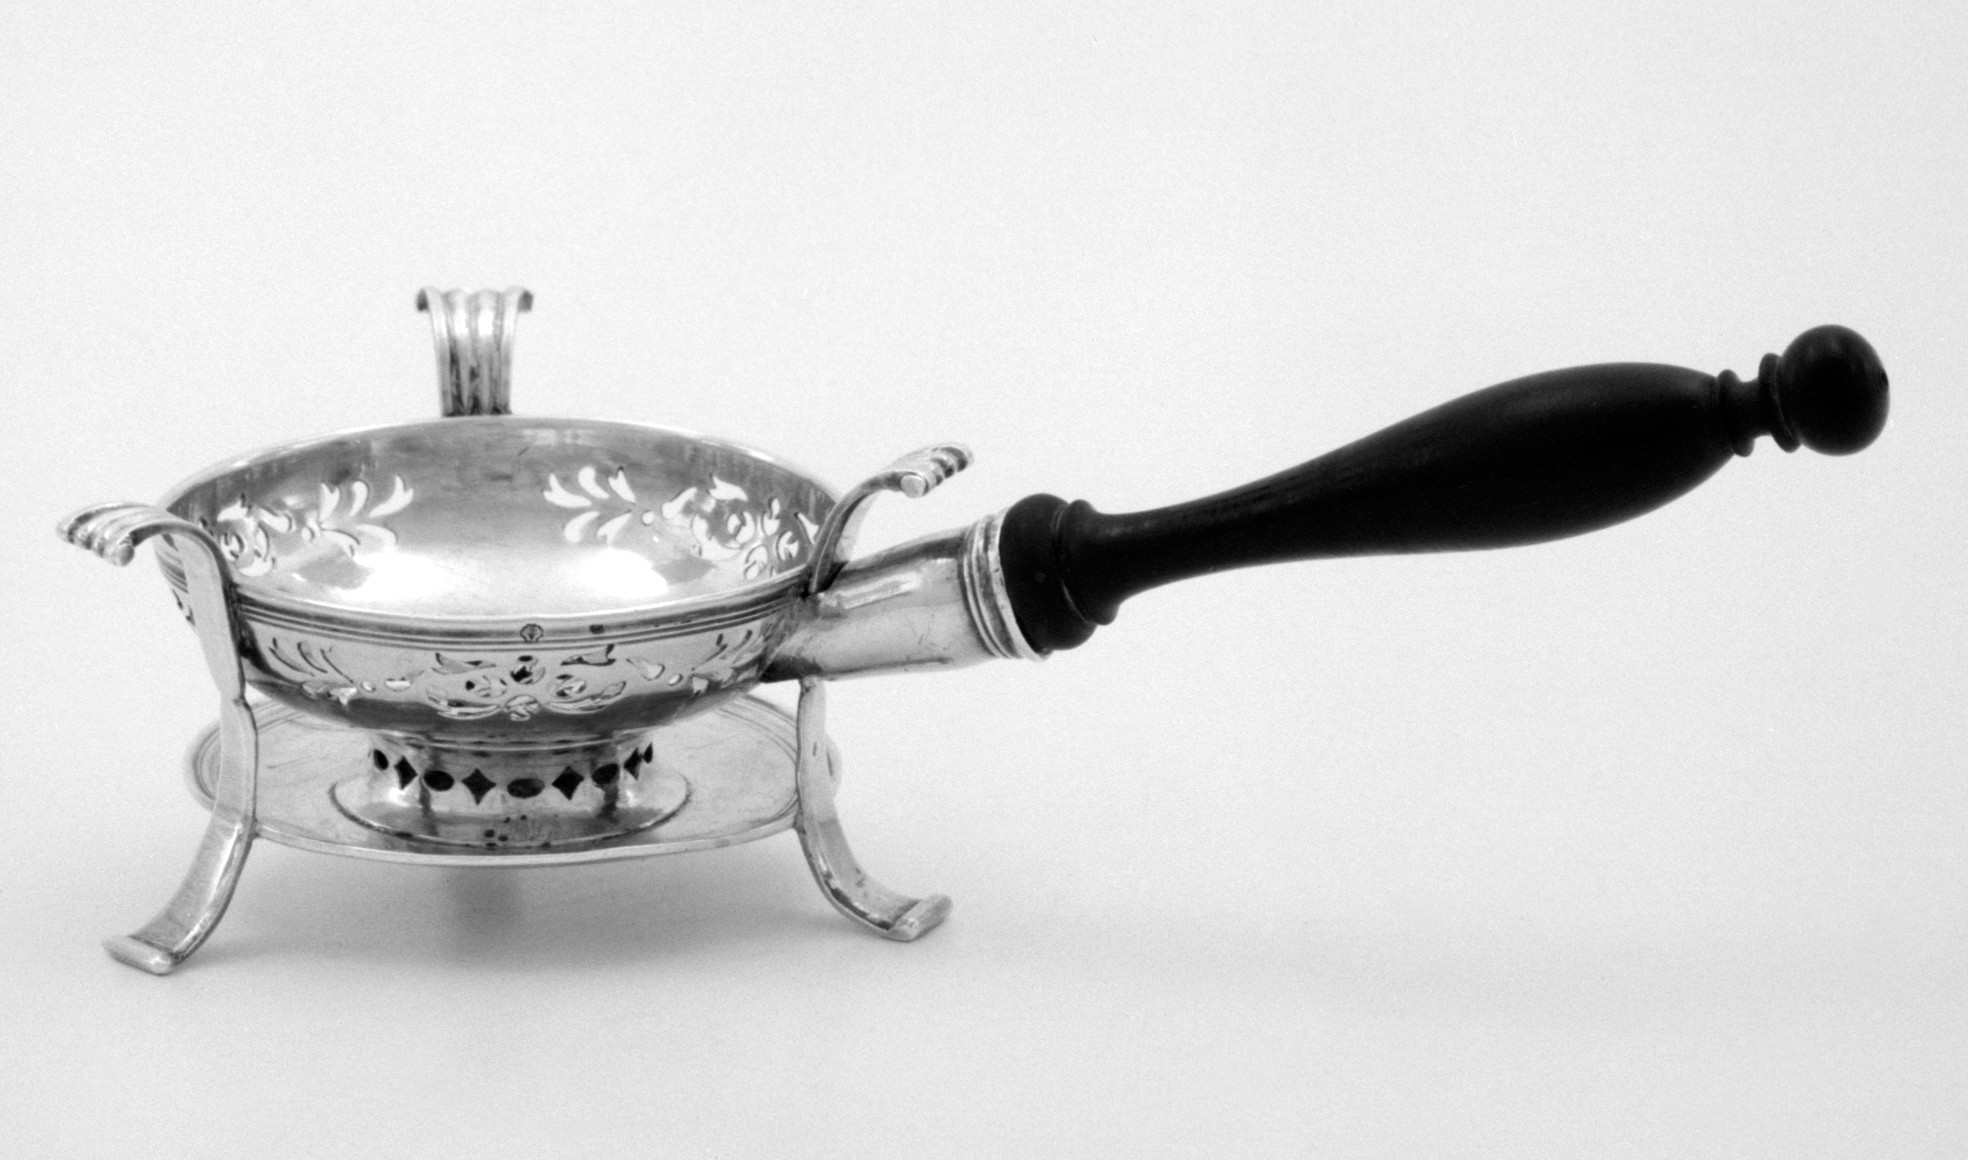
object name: brazier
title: Miniature brazier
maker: antoine plot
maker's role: maker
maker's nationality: french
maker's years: 1701-1772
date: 1756-1757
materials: silver, wood